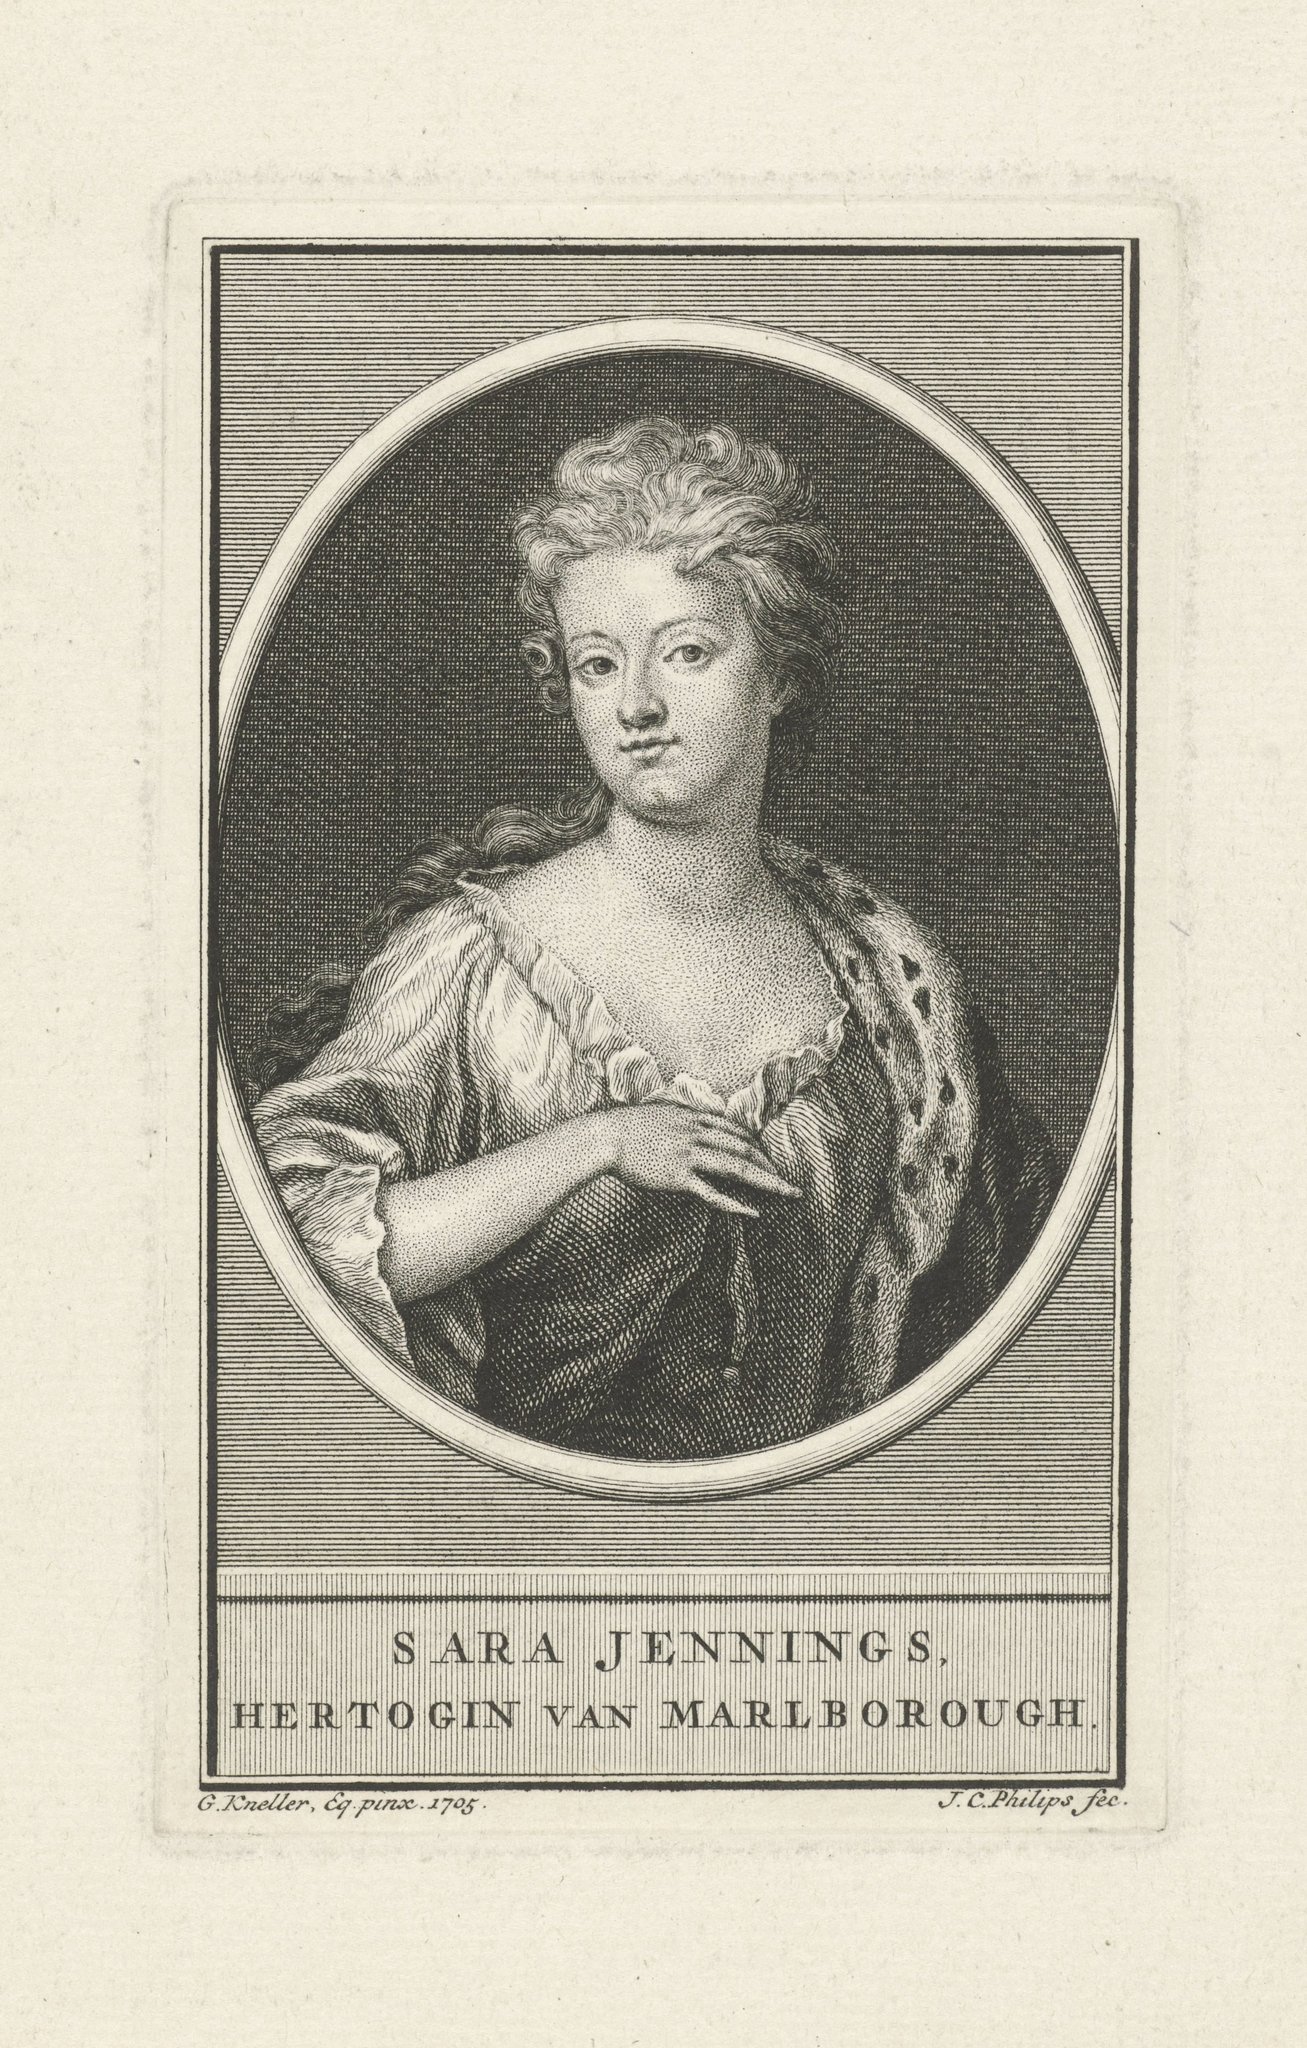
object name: print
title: Portret van Sarah Churchill (geboren Jennings)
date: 1736-1775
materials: paper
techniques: engraving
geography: amsterdam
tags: sarah churchill (hertogin van marlborough)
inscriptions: collector's mark: Lugt 2228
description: Portret van Sarah Churchill (geboren Jennings), hertogin van Marlborough.